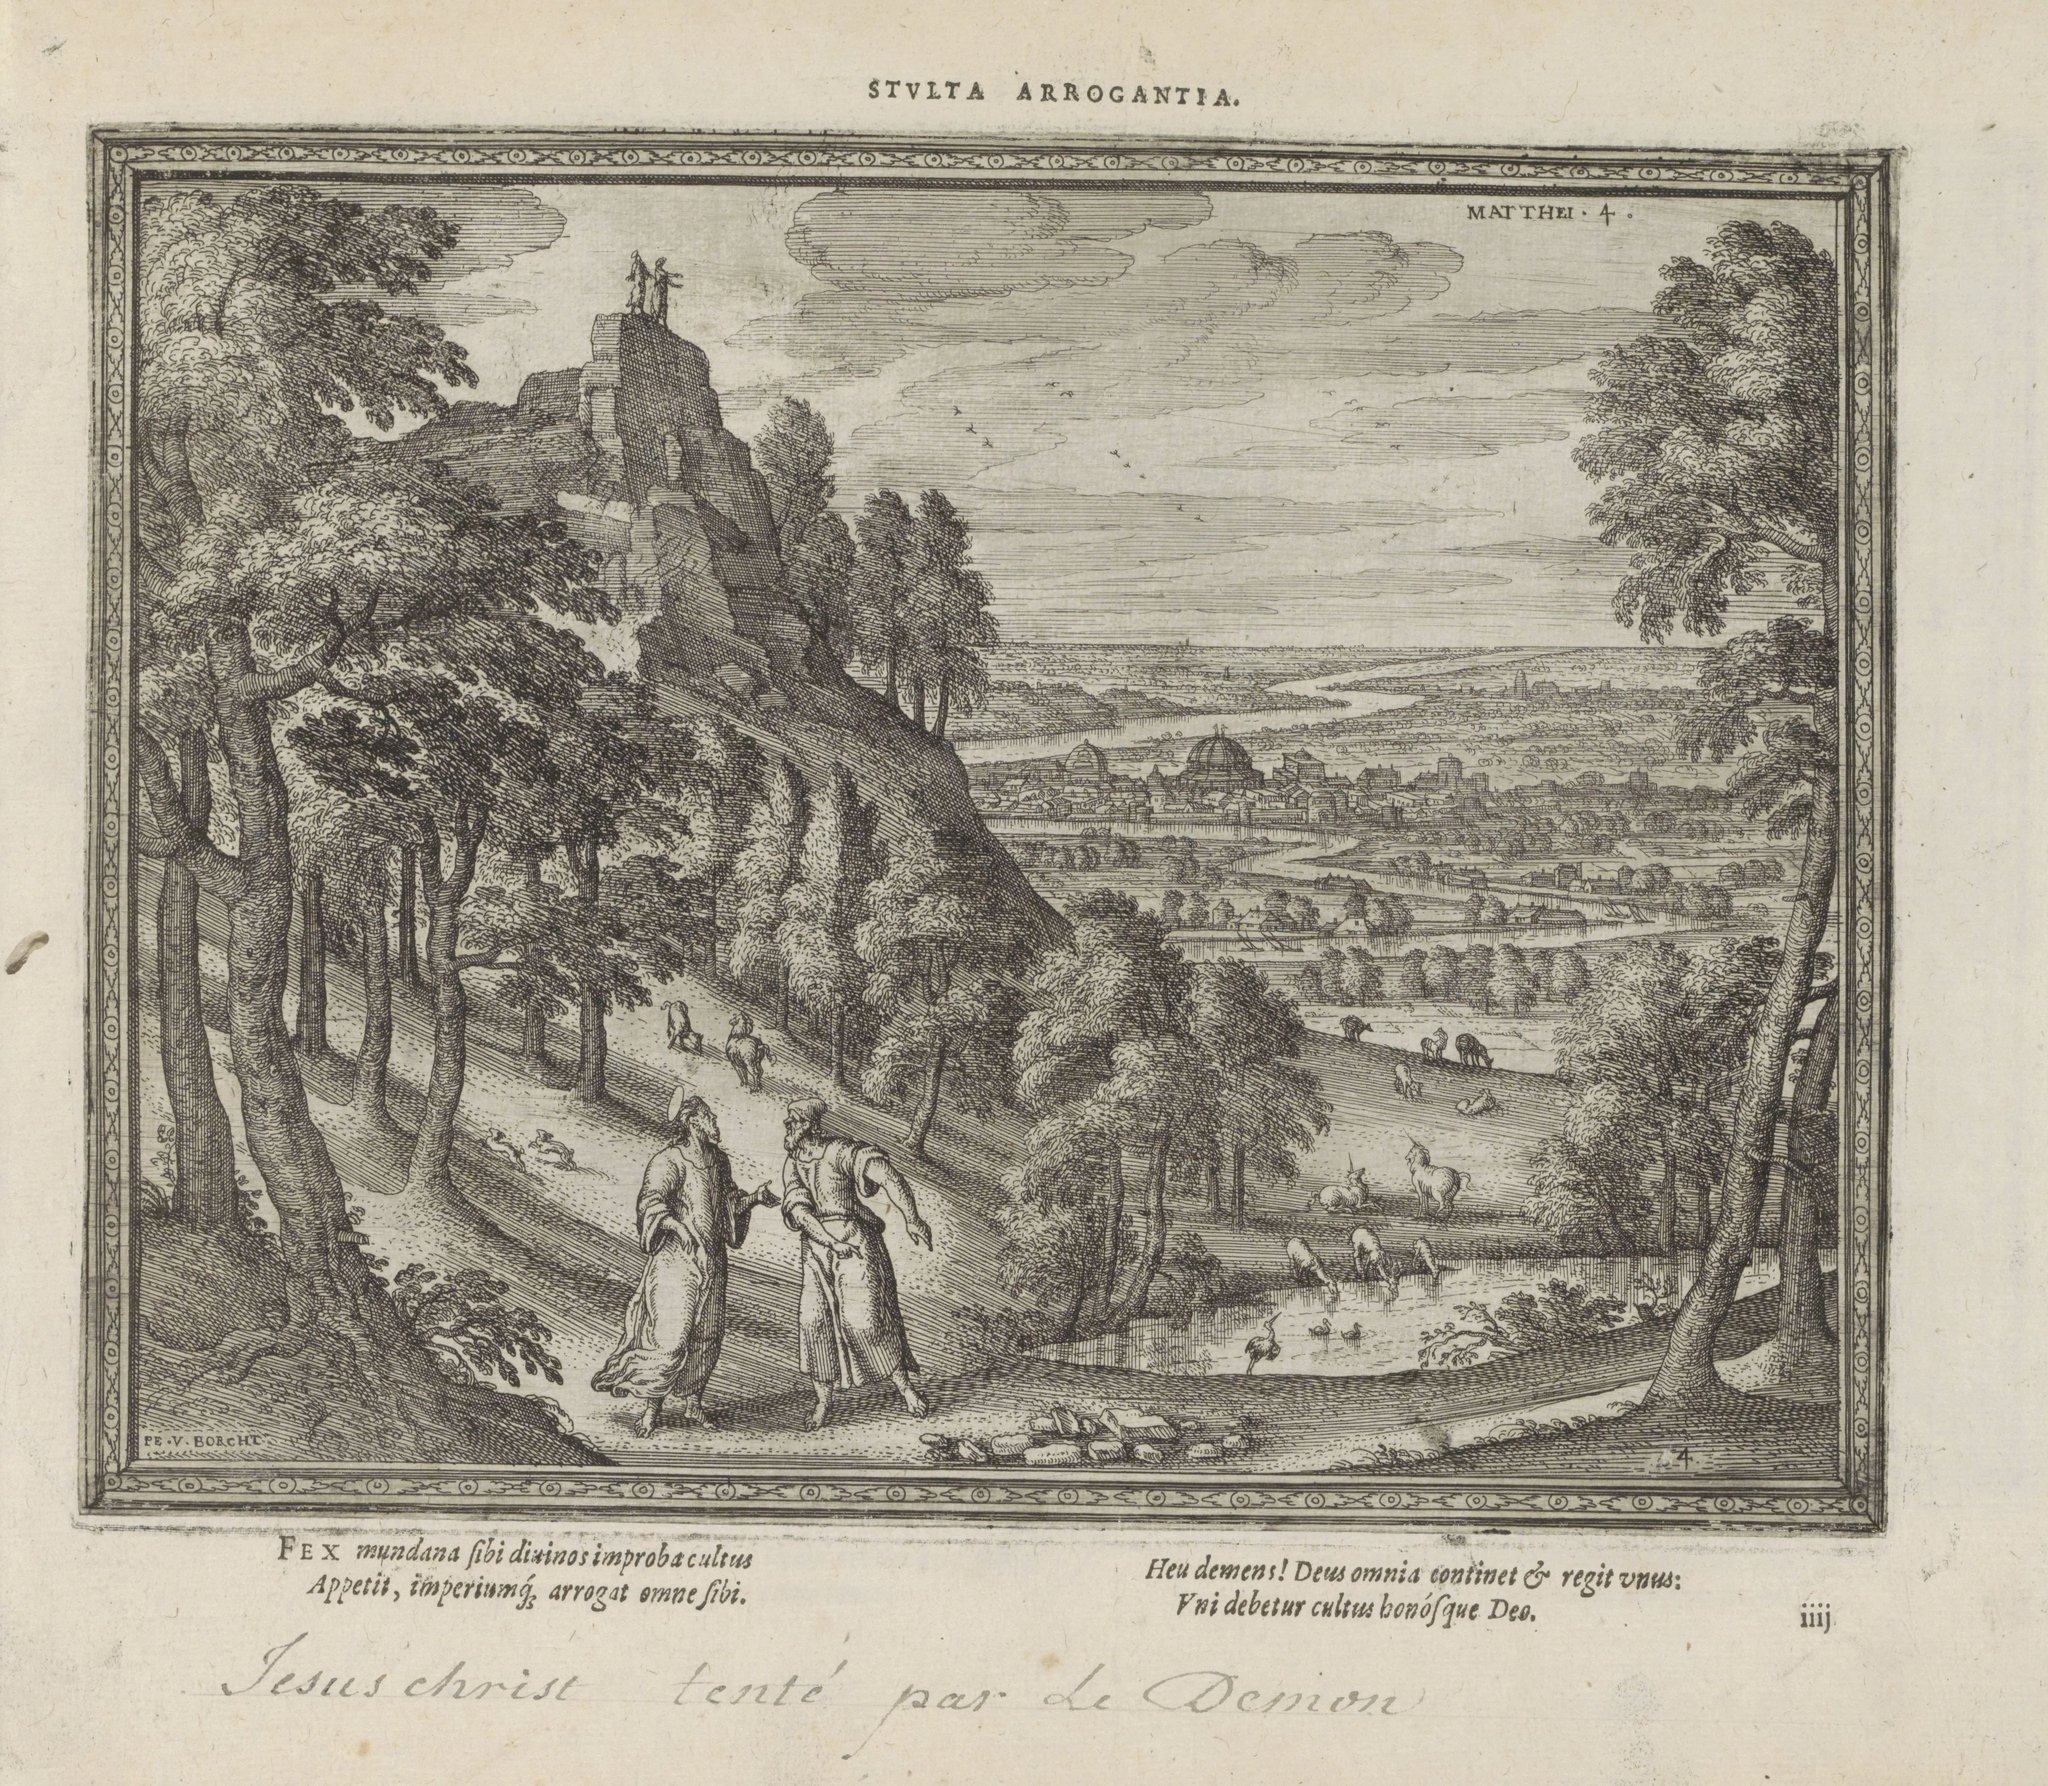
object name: album leaf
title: Stulta arrogantia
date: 1582-1593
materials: paper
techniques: etching, letterpress printing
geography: antwerp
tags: 'command these stones to become loaves of bread' ~ temptation of christ in the wilderness, water course, forest, wood, 'all these will i give you' (= the glory of the world) ~ temptation of christ in the wilderness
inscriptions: inscription: ‘Jesus Christ tenté par le Demion’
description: Boomrijk rivierlandschap met de Verzoeking van Christus. Op de voorgrond wijst de beproever op een aantal stenen op de grond en daagt Christus uit ze in broden te veranderen. Op de top van de berg belooft hij Christus alle koninkrijken van de wereld (Matt. 4:1-11). Met een motto in het Latijn boven de voorstelling en een vierregelig onderschrift in het Latijn onder de prent. De prent maakt deel uit van een album.